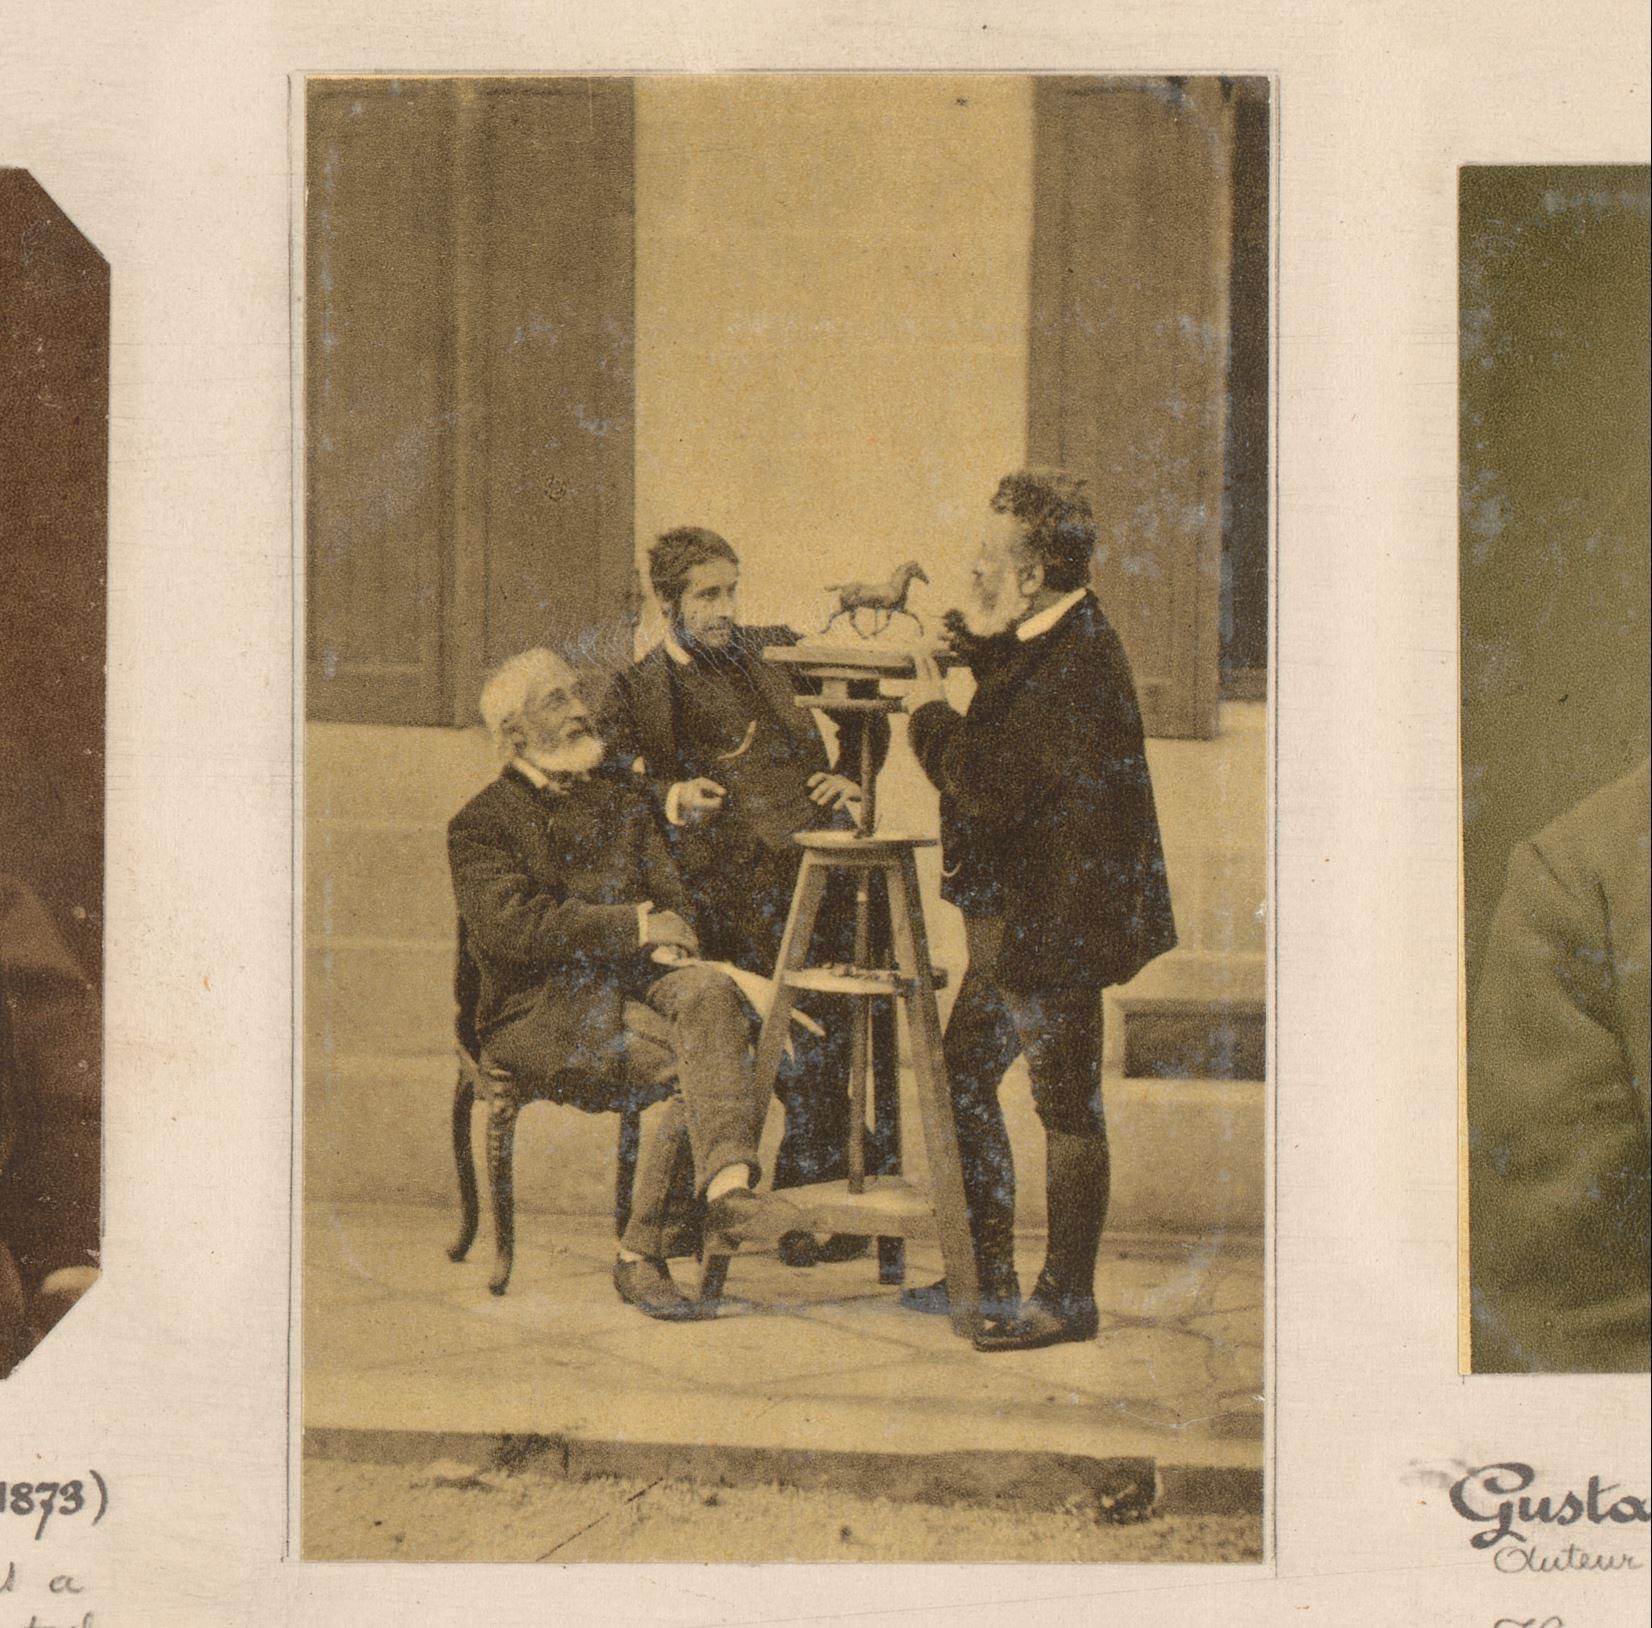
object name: photograph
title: Meissonnier (en 1880)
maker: Anonymous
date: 1880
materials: paper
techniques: rotogravure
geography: france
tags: lyon, paris, print maker, draughtsman, jean louis ernest meissonier, artist (in general), france